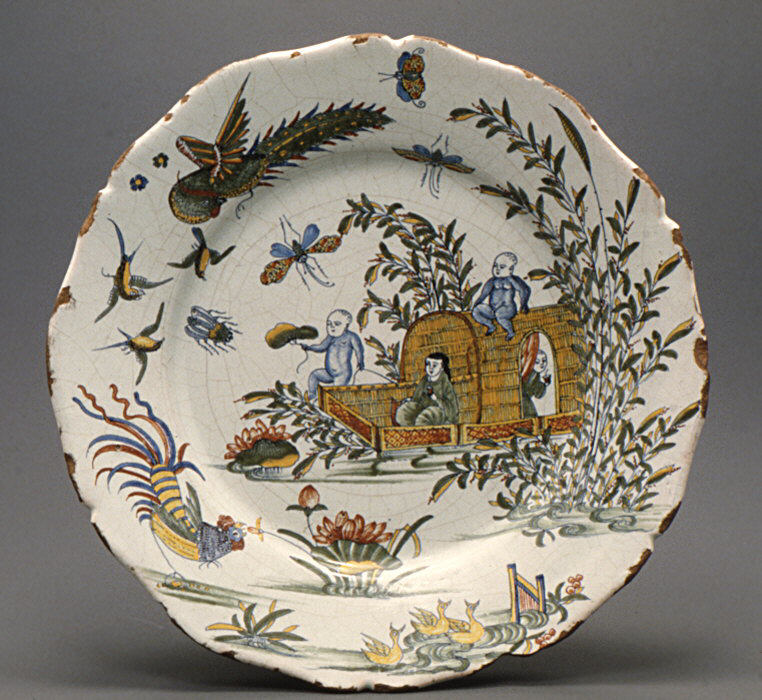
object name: plate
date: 1720-1750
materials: faience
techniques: glazing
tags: birds,boys,girls,boats